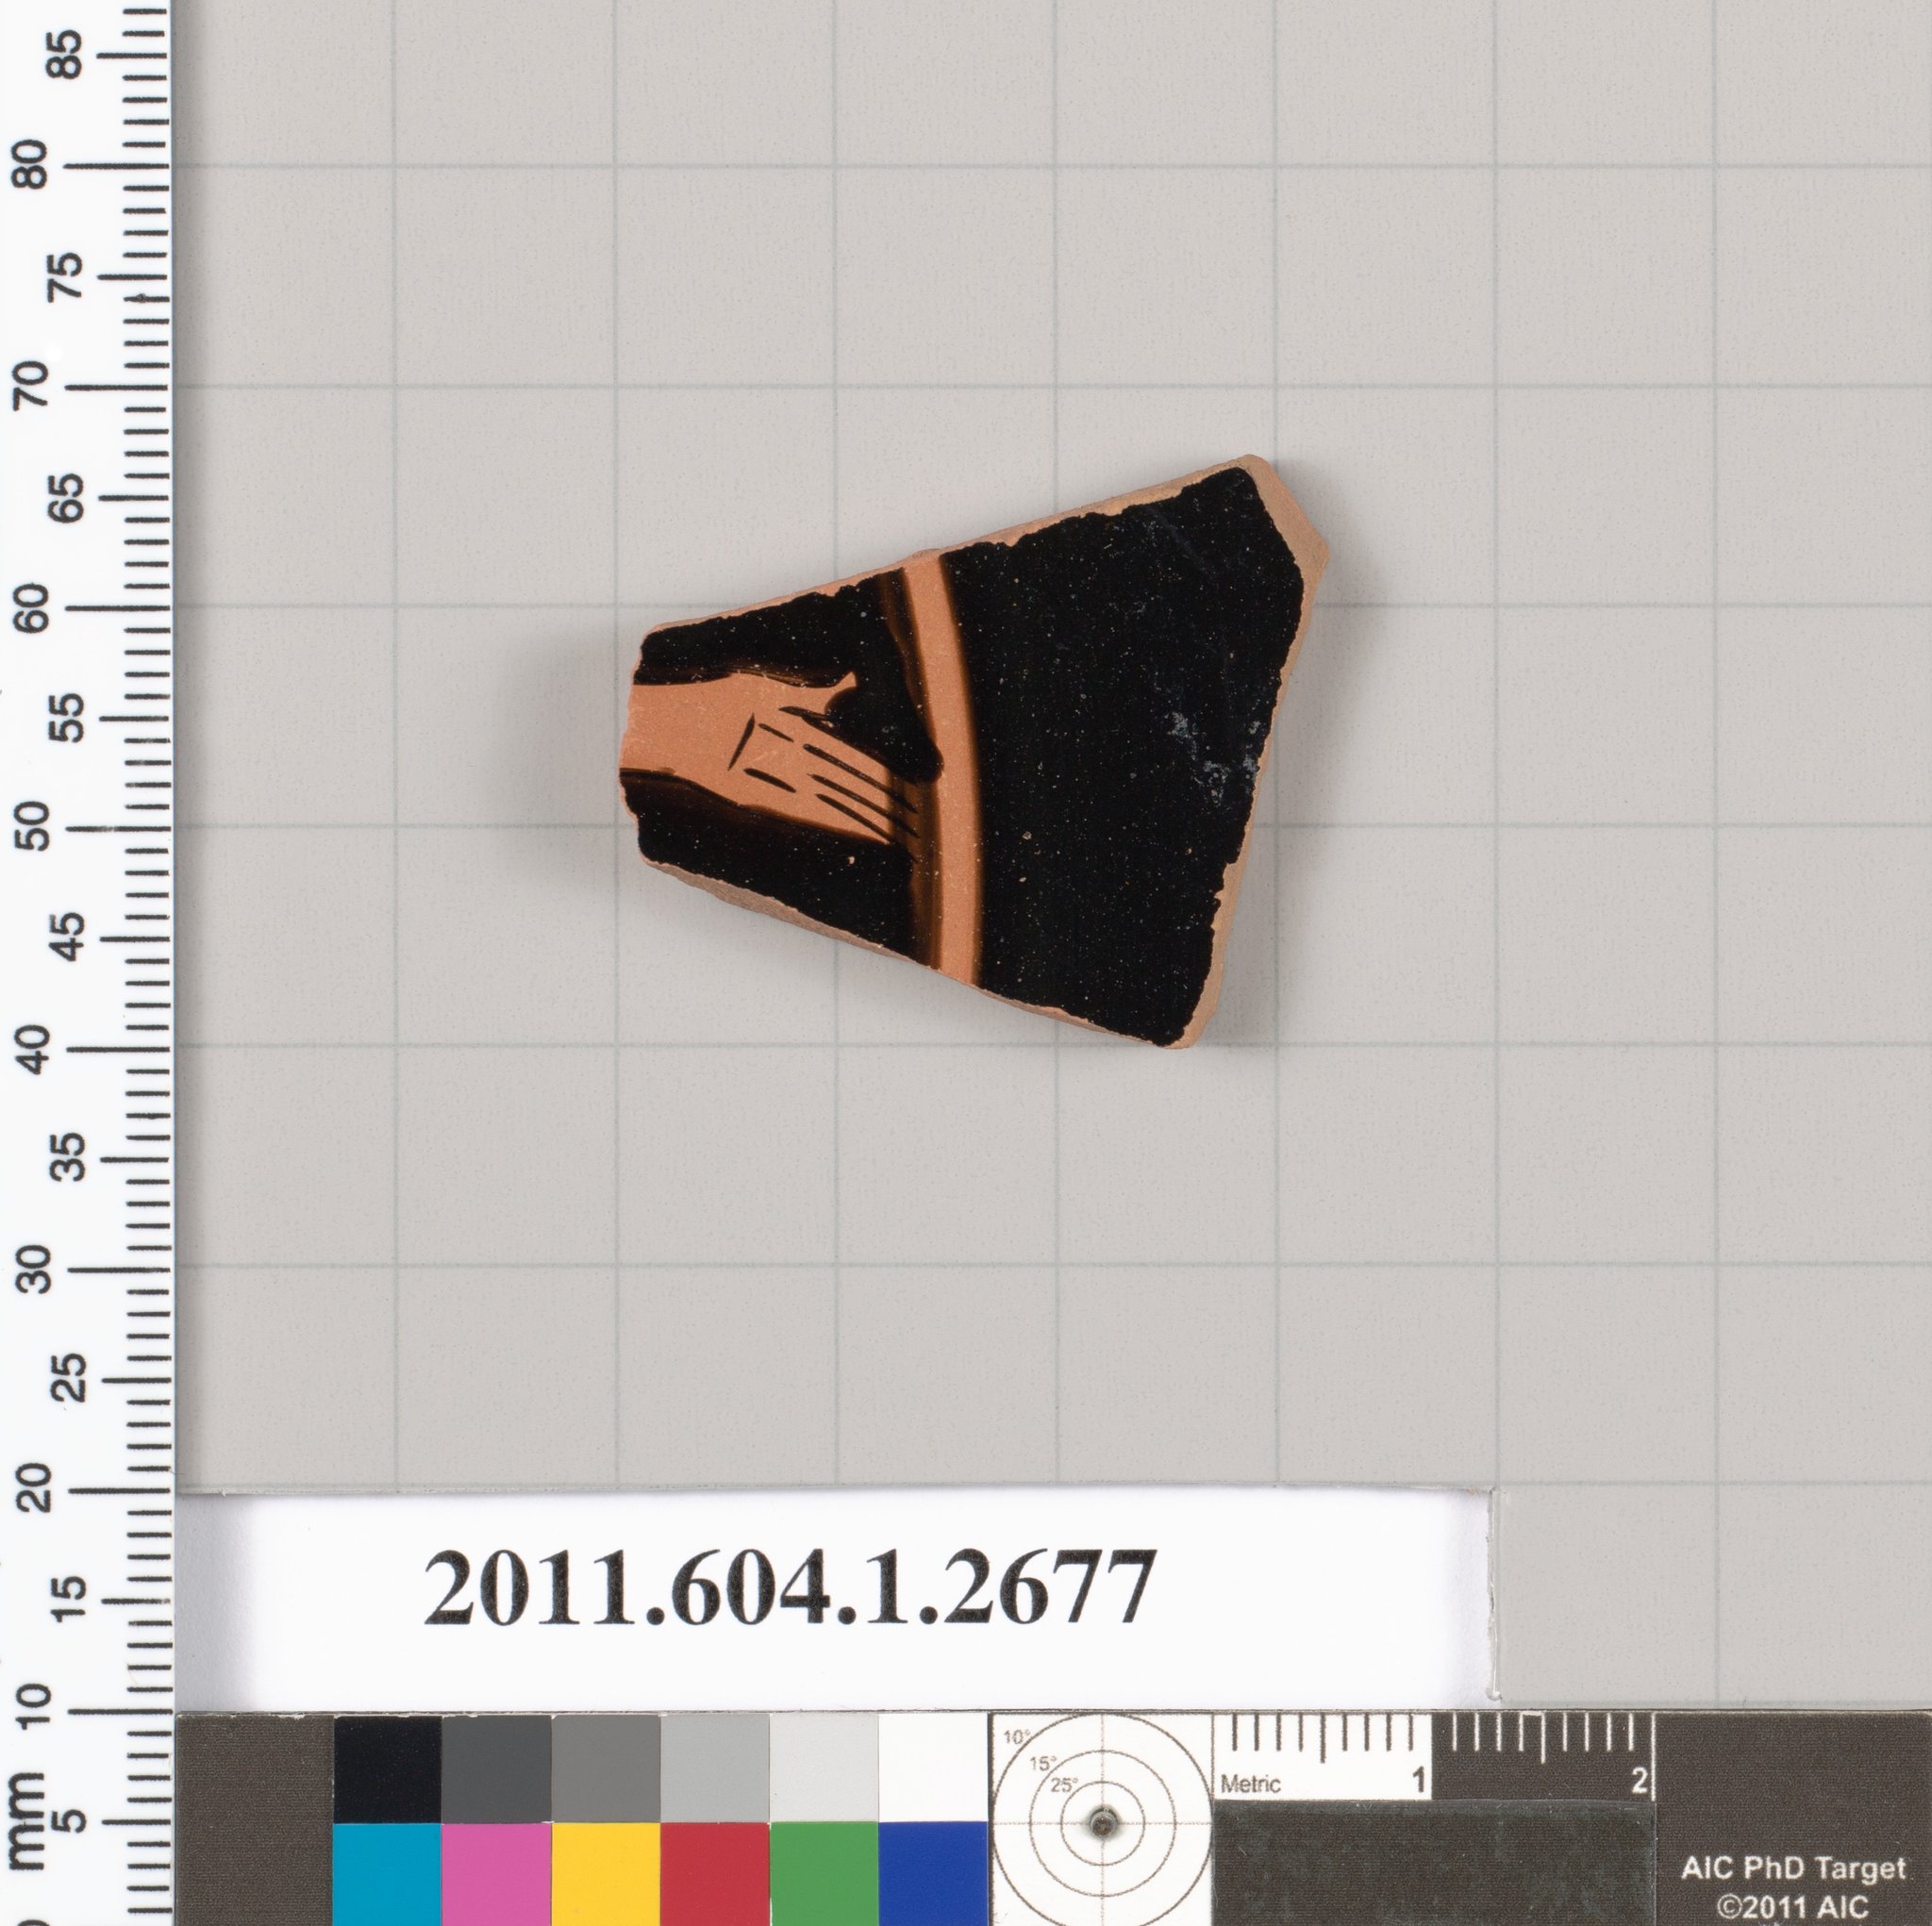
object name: kylix fragment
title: Terracotta fragment of a kylix (drinking cup)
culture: greek, attic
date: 500-476 BCE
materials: terracotta